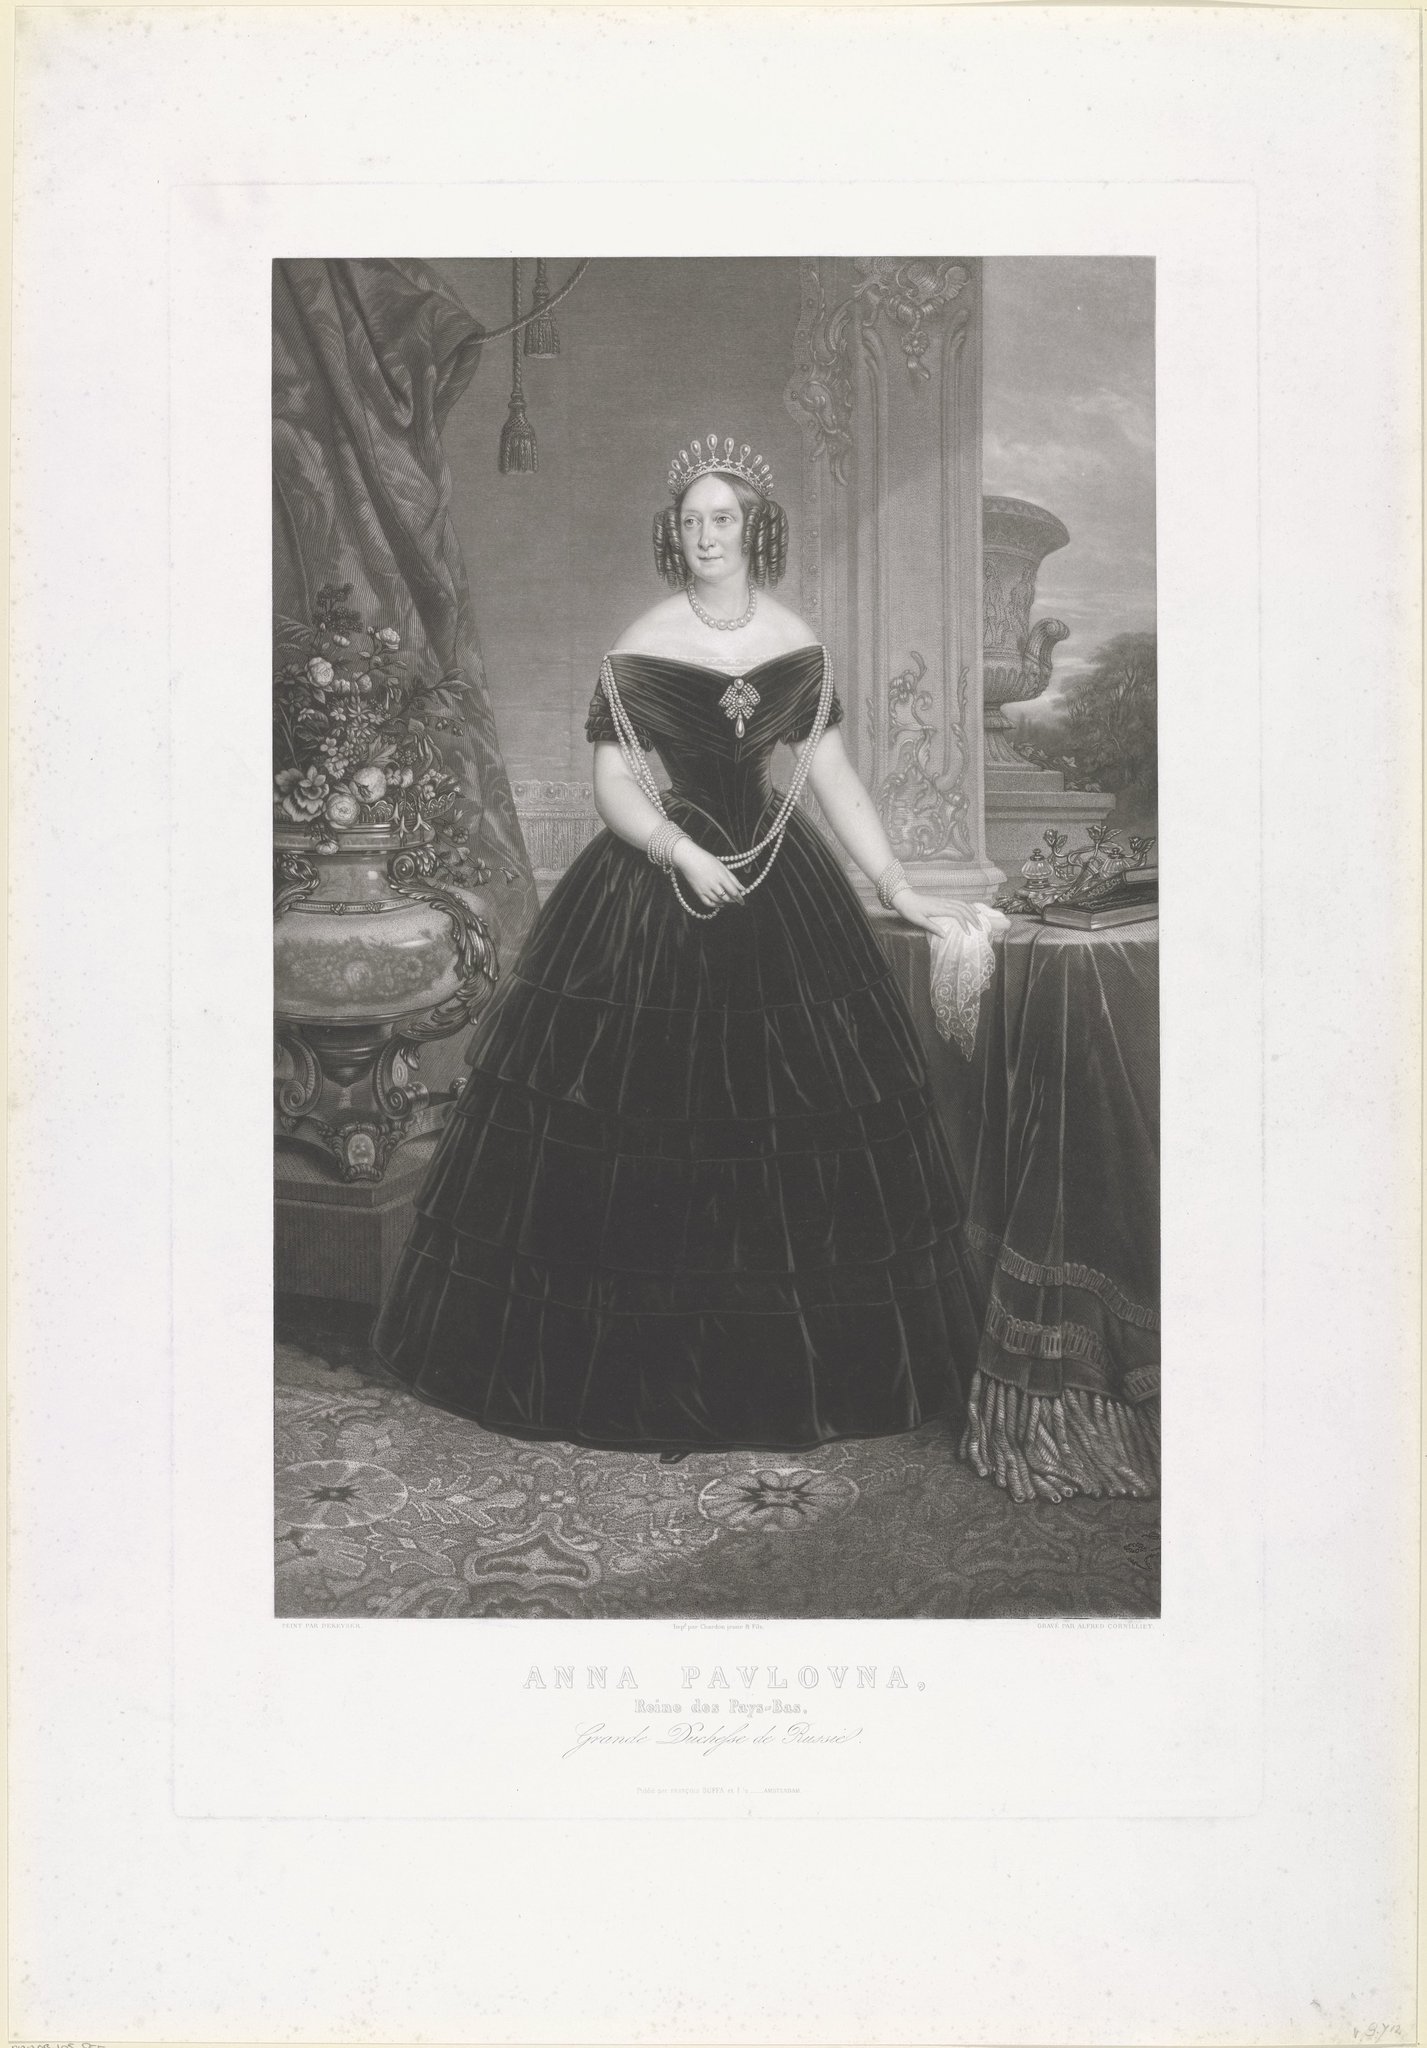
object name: print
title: Portret van Anna Paulowna Romanowa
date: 1840-1871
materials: paper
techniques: etching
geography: paris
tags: the hague, anna paulowna romanowa, historical persons - bb - woman, ruler, sovereign - bb - female ruler, book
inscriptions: collector's mark: Lugt 963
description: Portret van Anna Paulowna. Ze staat naast een vaas en een tafel met daarop boeken. In de ondermarge haar naam en titels.